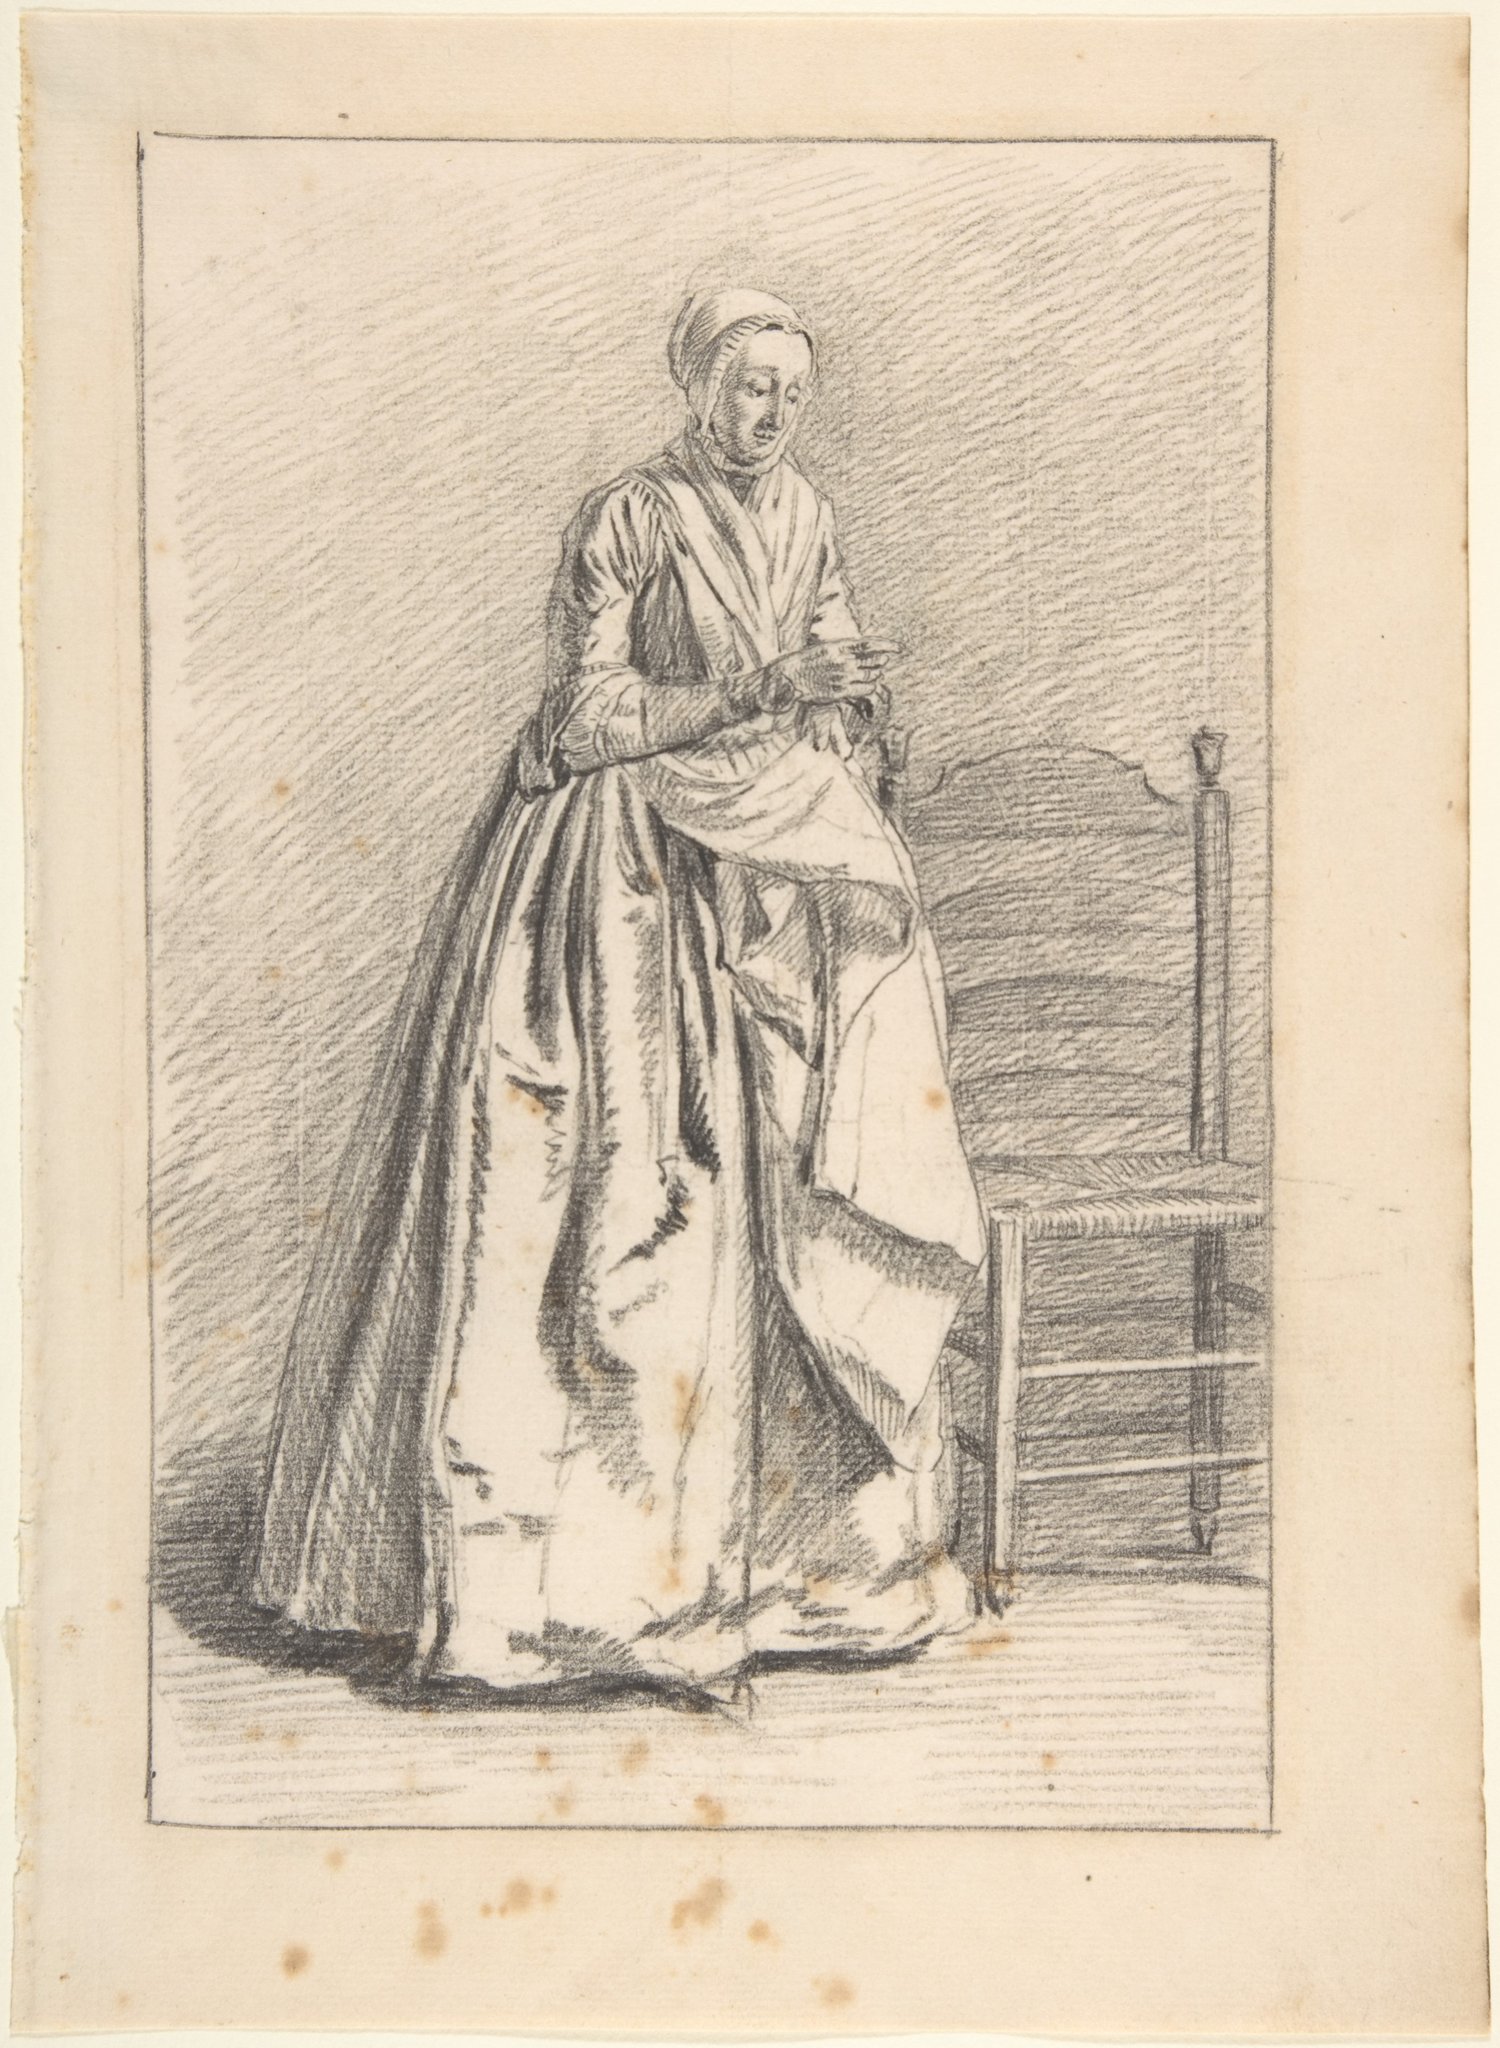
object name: drawing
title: A Woman Standing next to a Chair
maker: nicolaas muys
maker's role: artist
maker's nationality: dutch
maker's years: 1740-1808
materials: chalk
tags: women,chairs